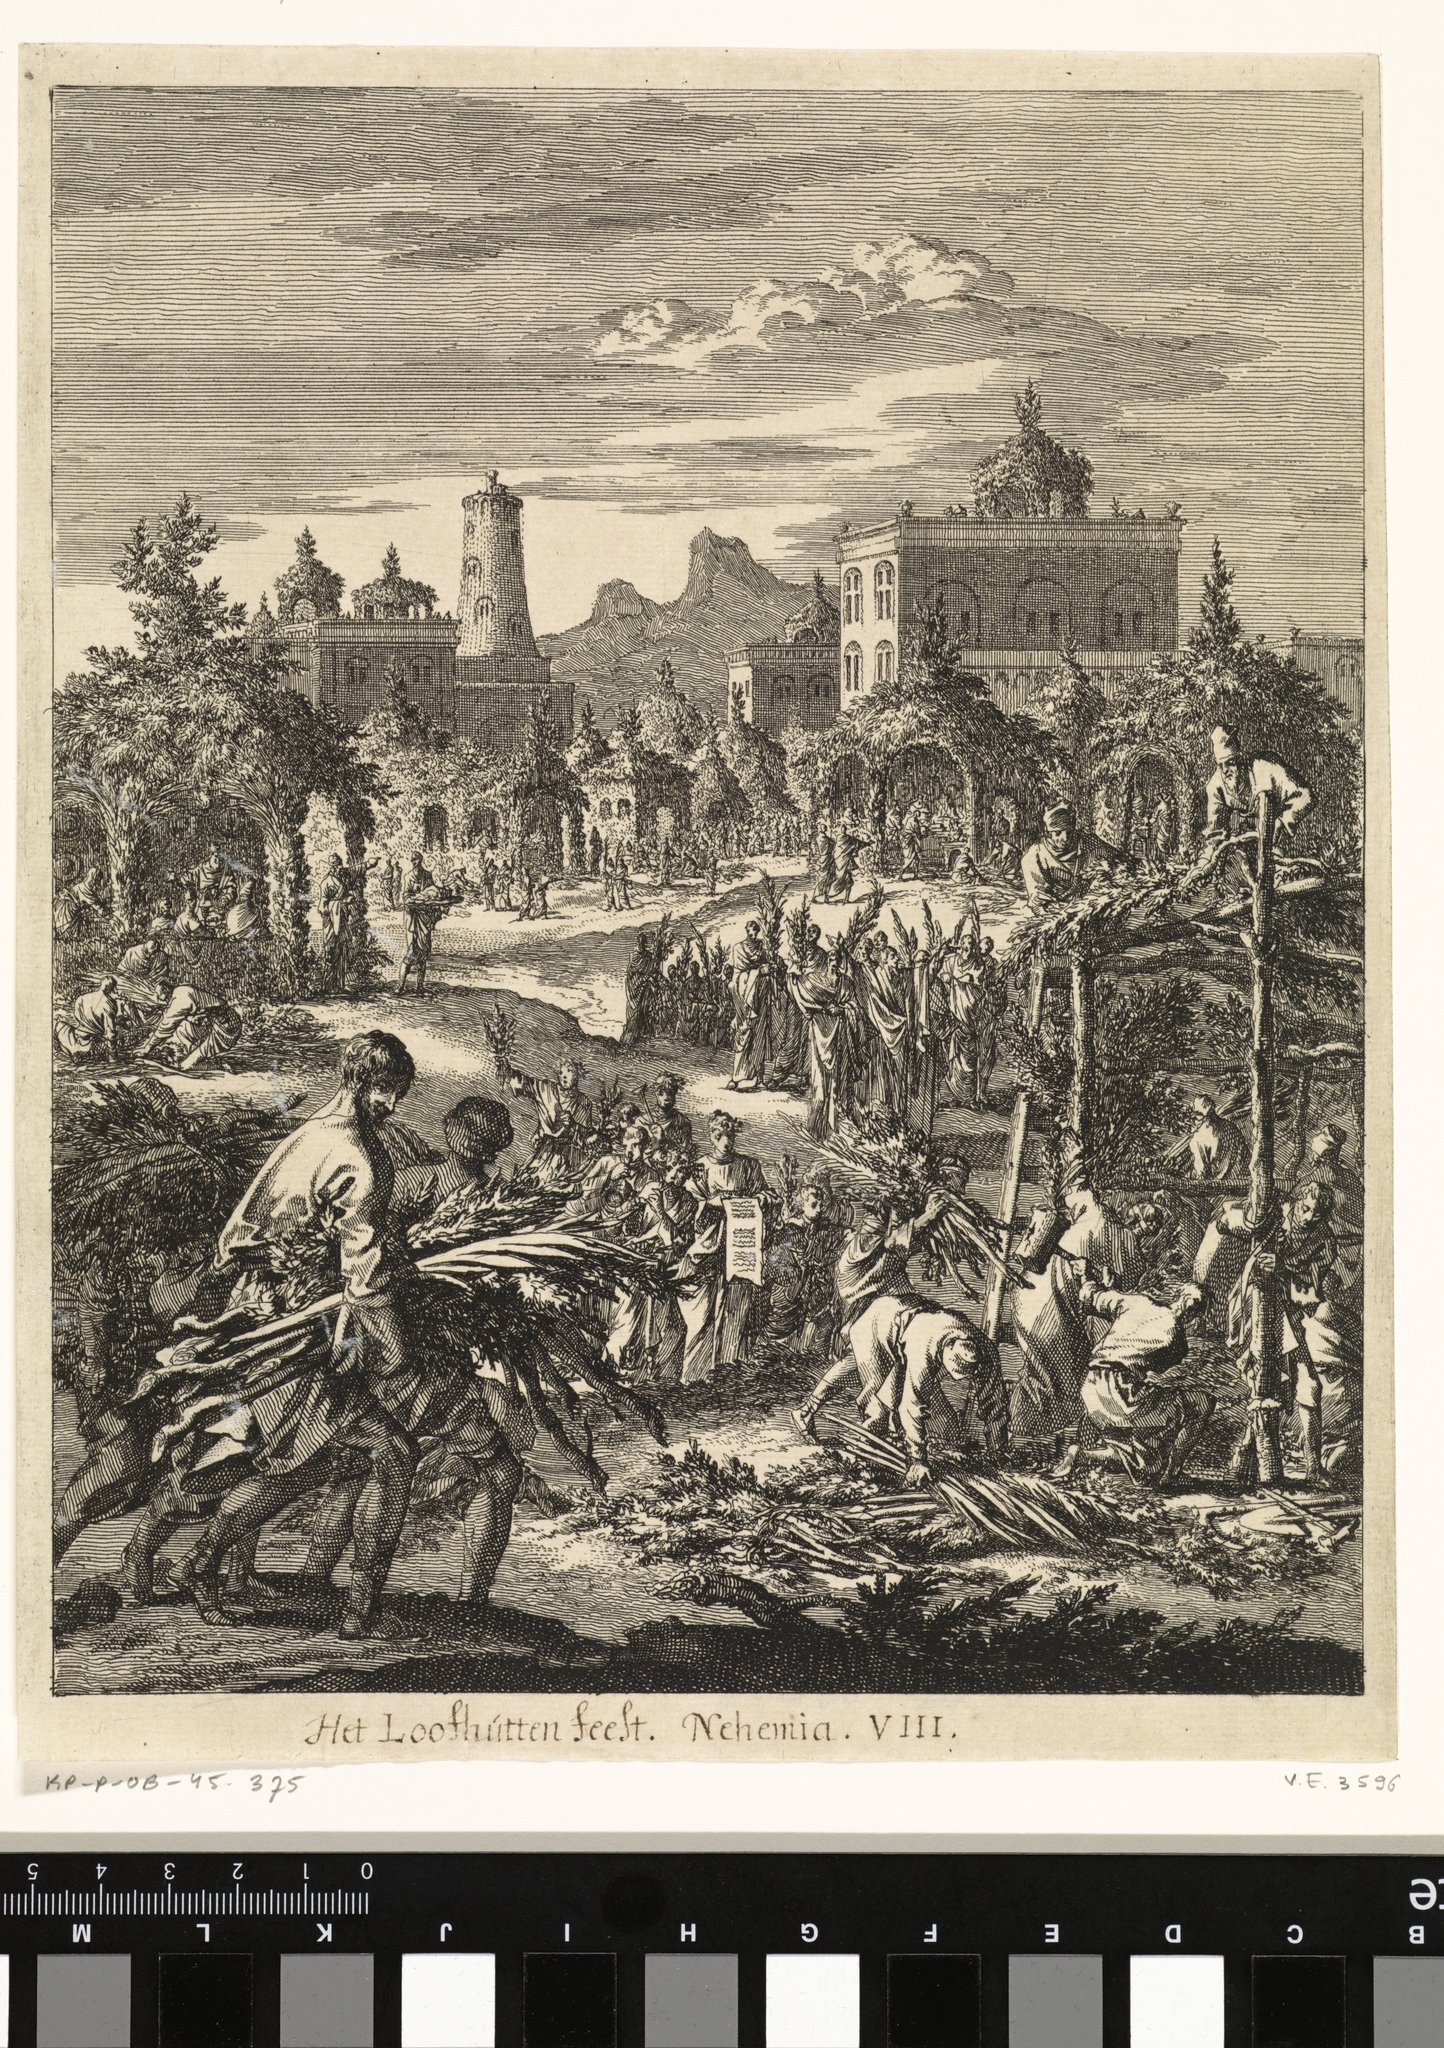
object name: print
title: Loofhuttenfeest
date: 1708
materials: paper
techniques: etching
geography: amsterdam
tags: 'sukkot', feast of the tabernacles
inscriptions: collector's mark: Lugt 2228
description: Proefdruk van een prent welke is opgenomen als illustratie in: Historiae Celebriores Veteris Testamenti. Christoph Weigel, 1708.